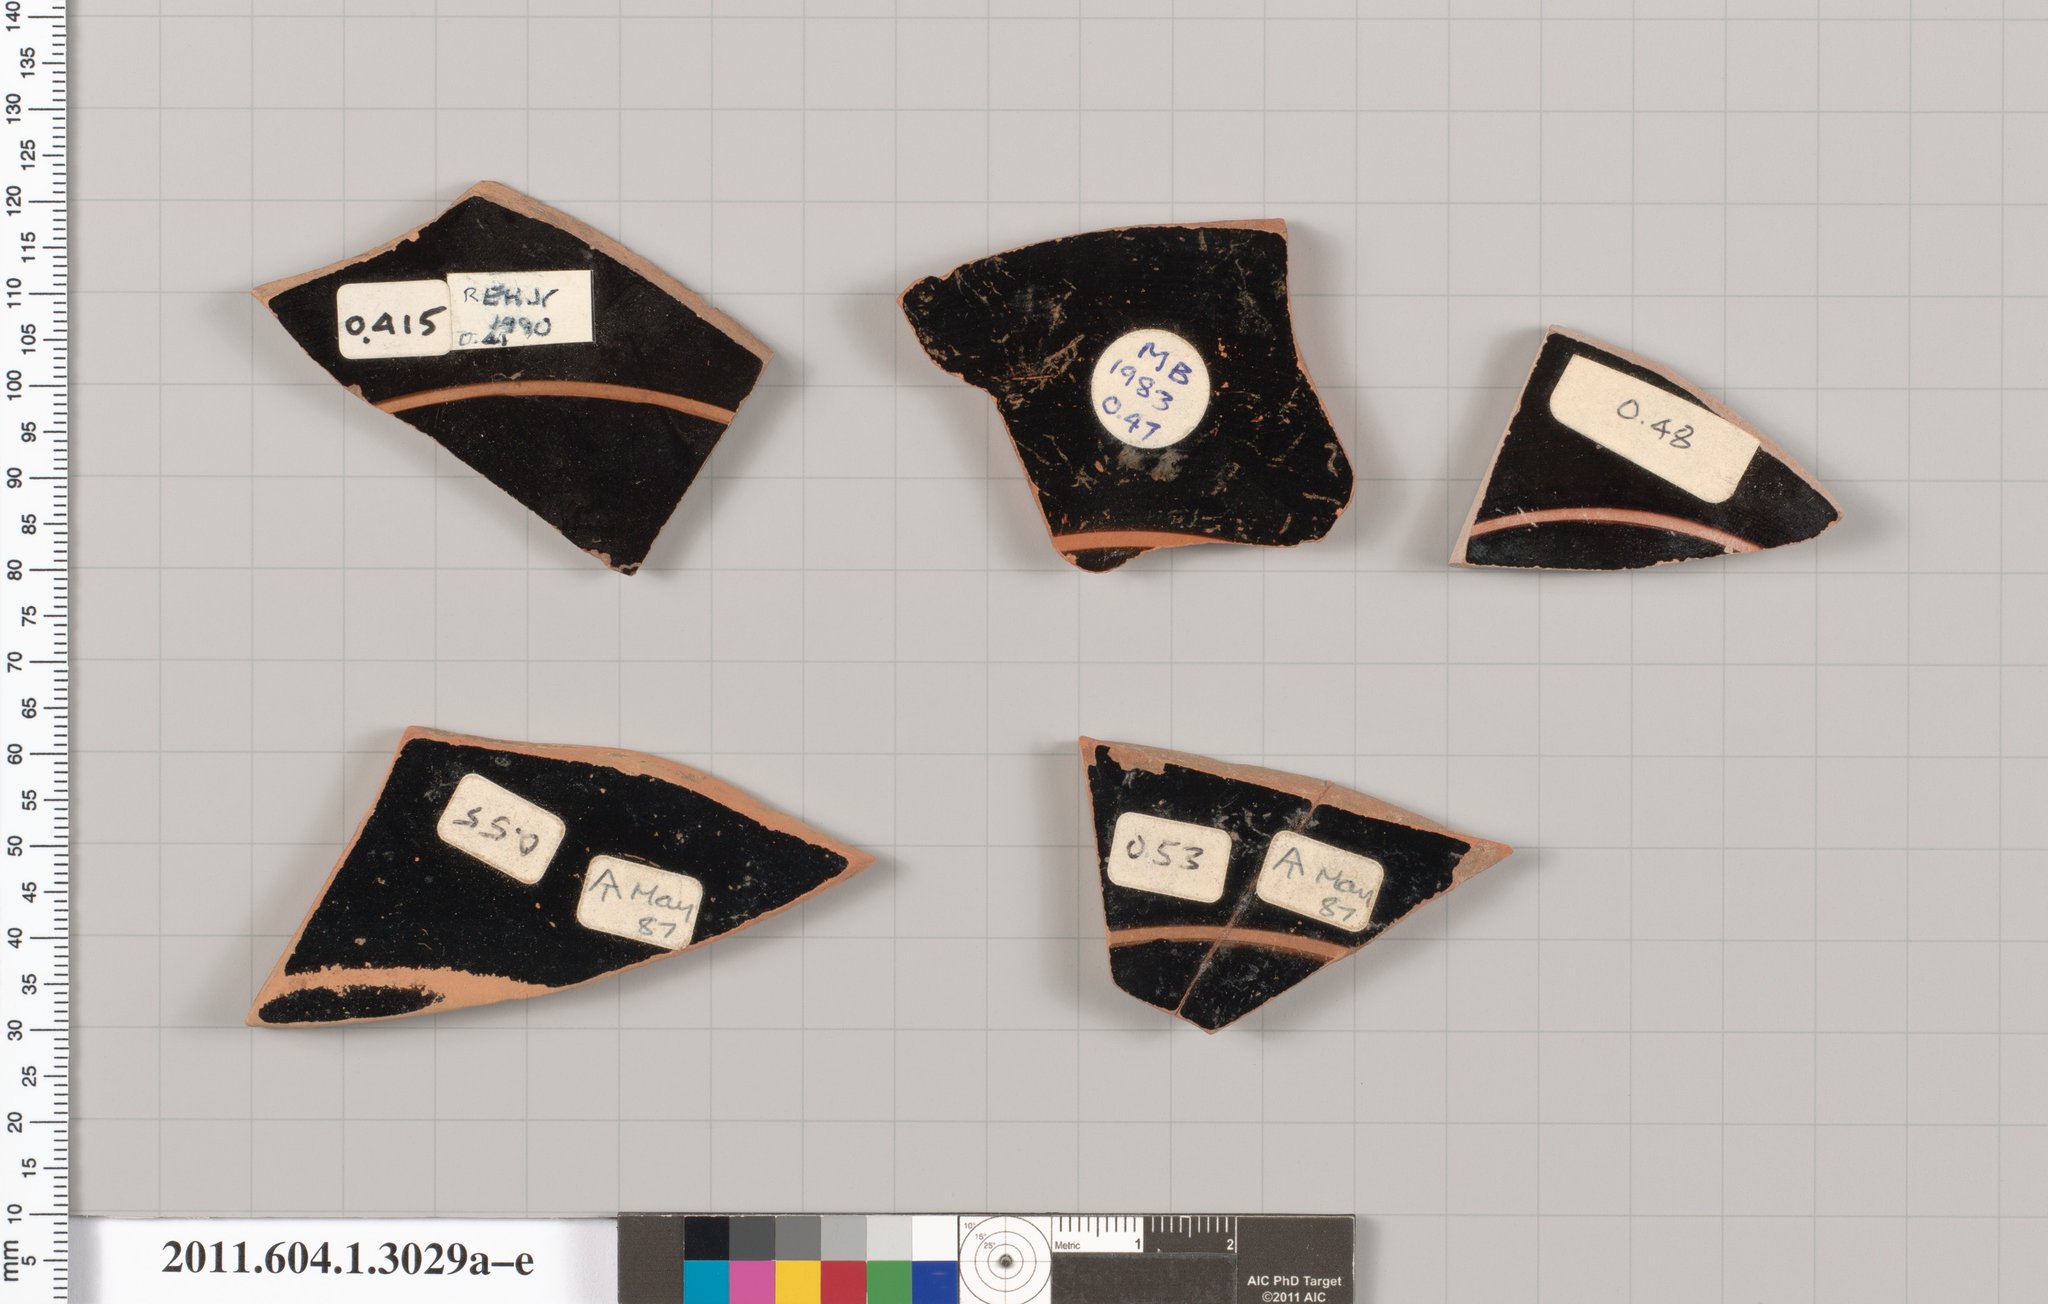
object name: kylix fragment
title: Terracotta fragments of kylikes (drinking cups)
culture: greek, attic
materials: terracotta